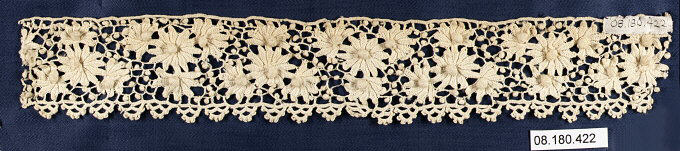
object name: fragment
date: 1801-1900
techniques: crochet